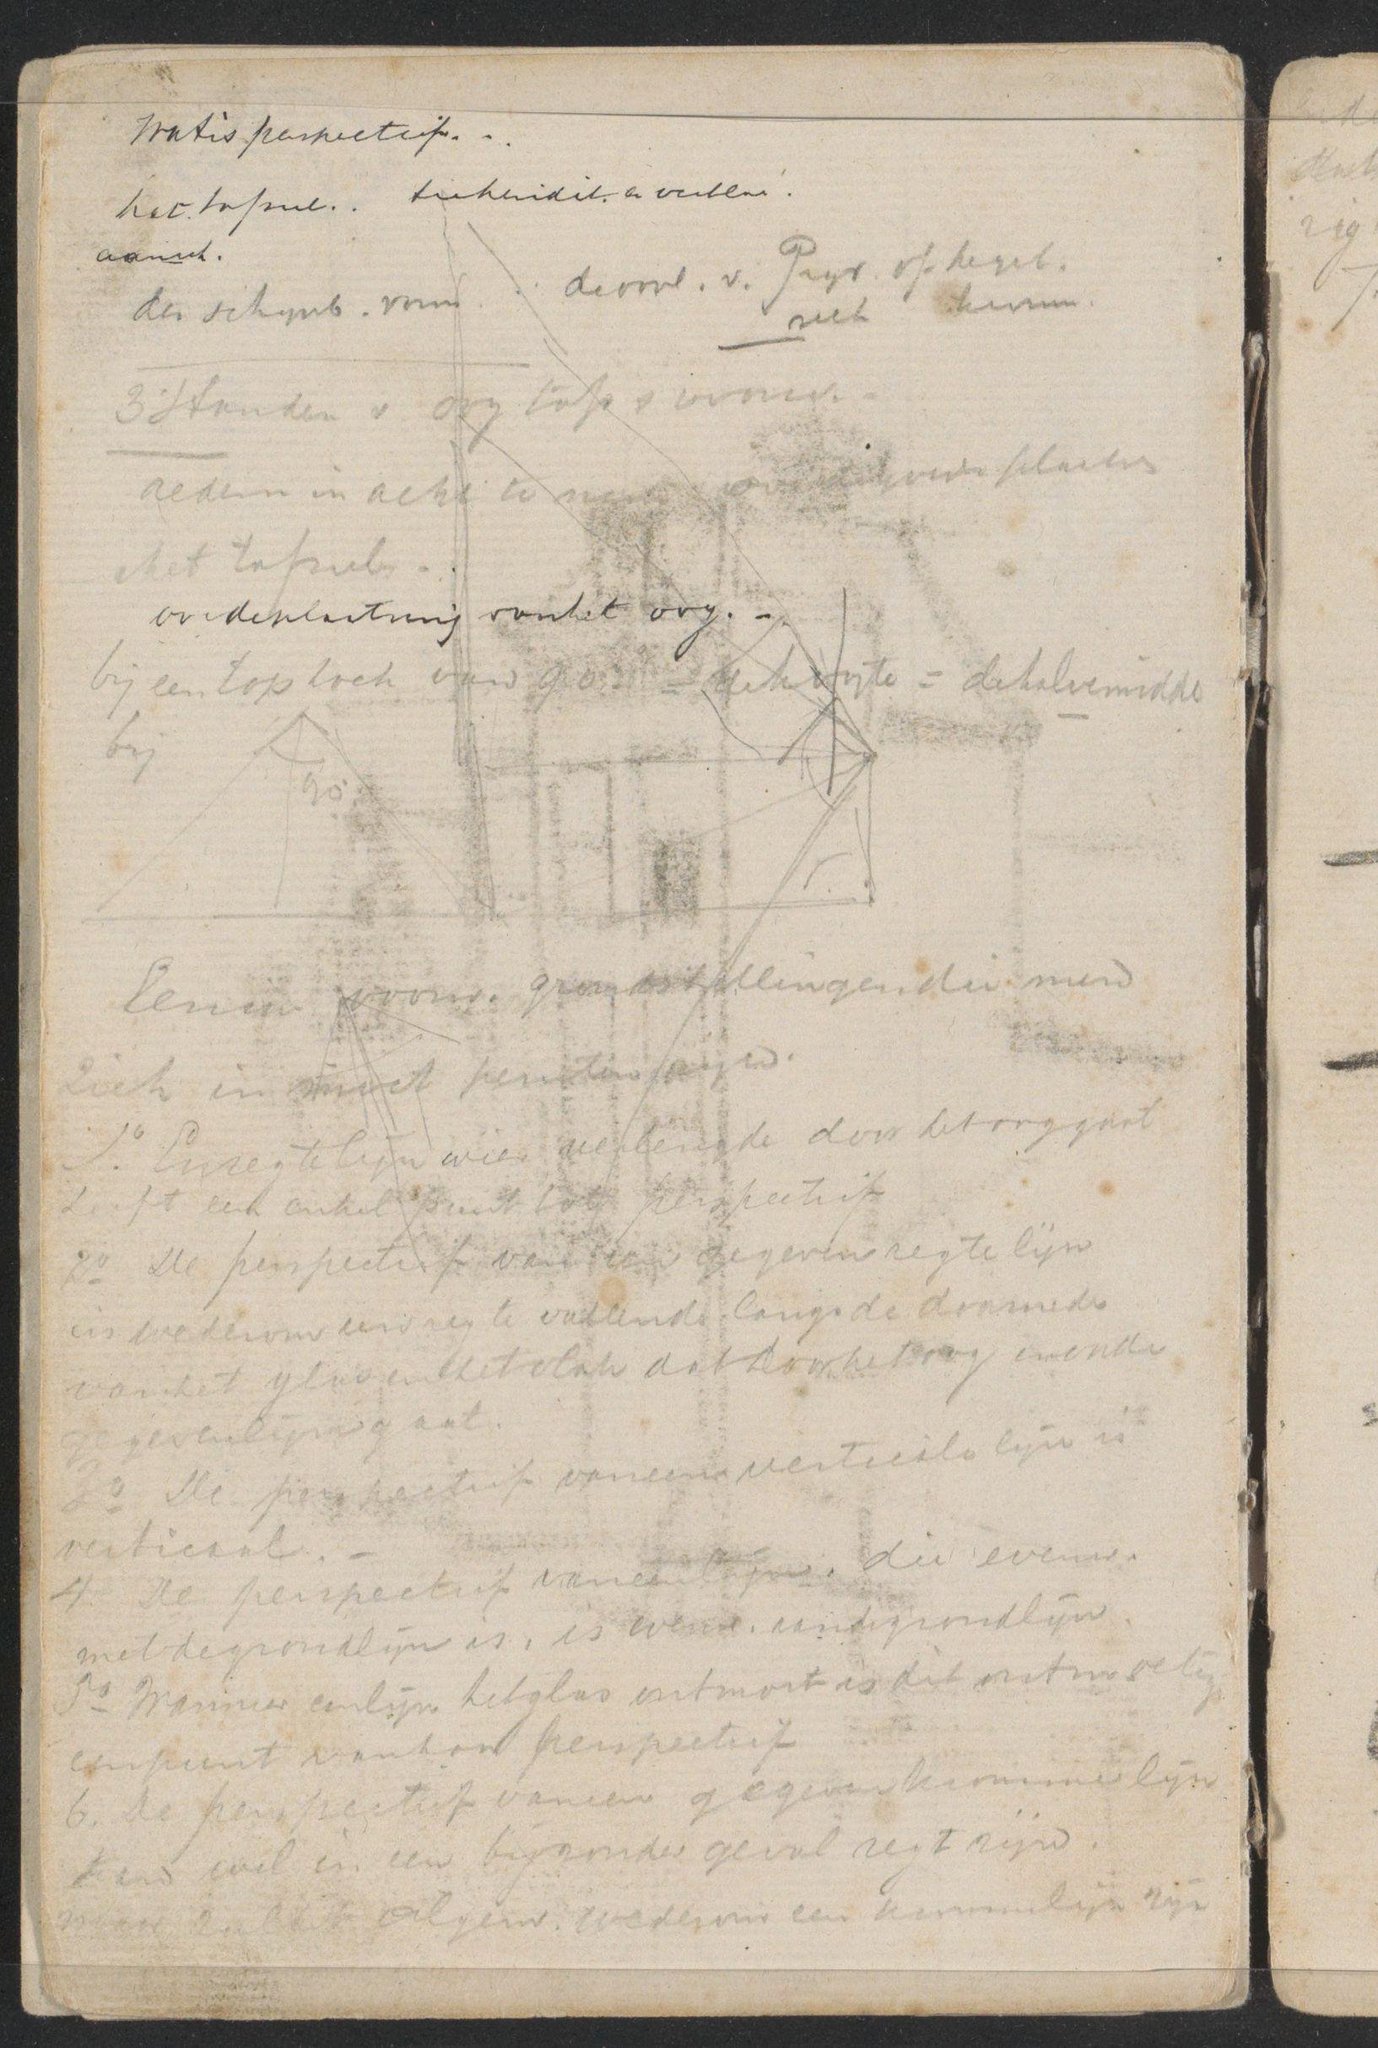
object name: sketchbook leaf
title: Perspectiefstudies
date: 1880-1882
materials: paper, pencil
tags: mathematical perspective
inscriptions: annotation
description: Blad 27 verso uit een schetsboek met 10 bladen.